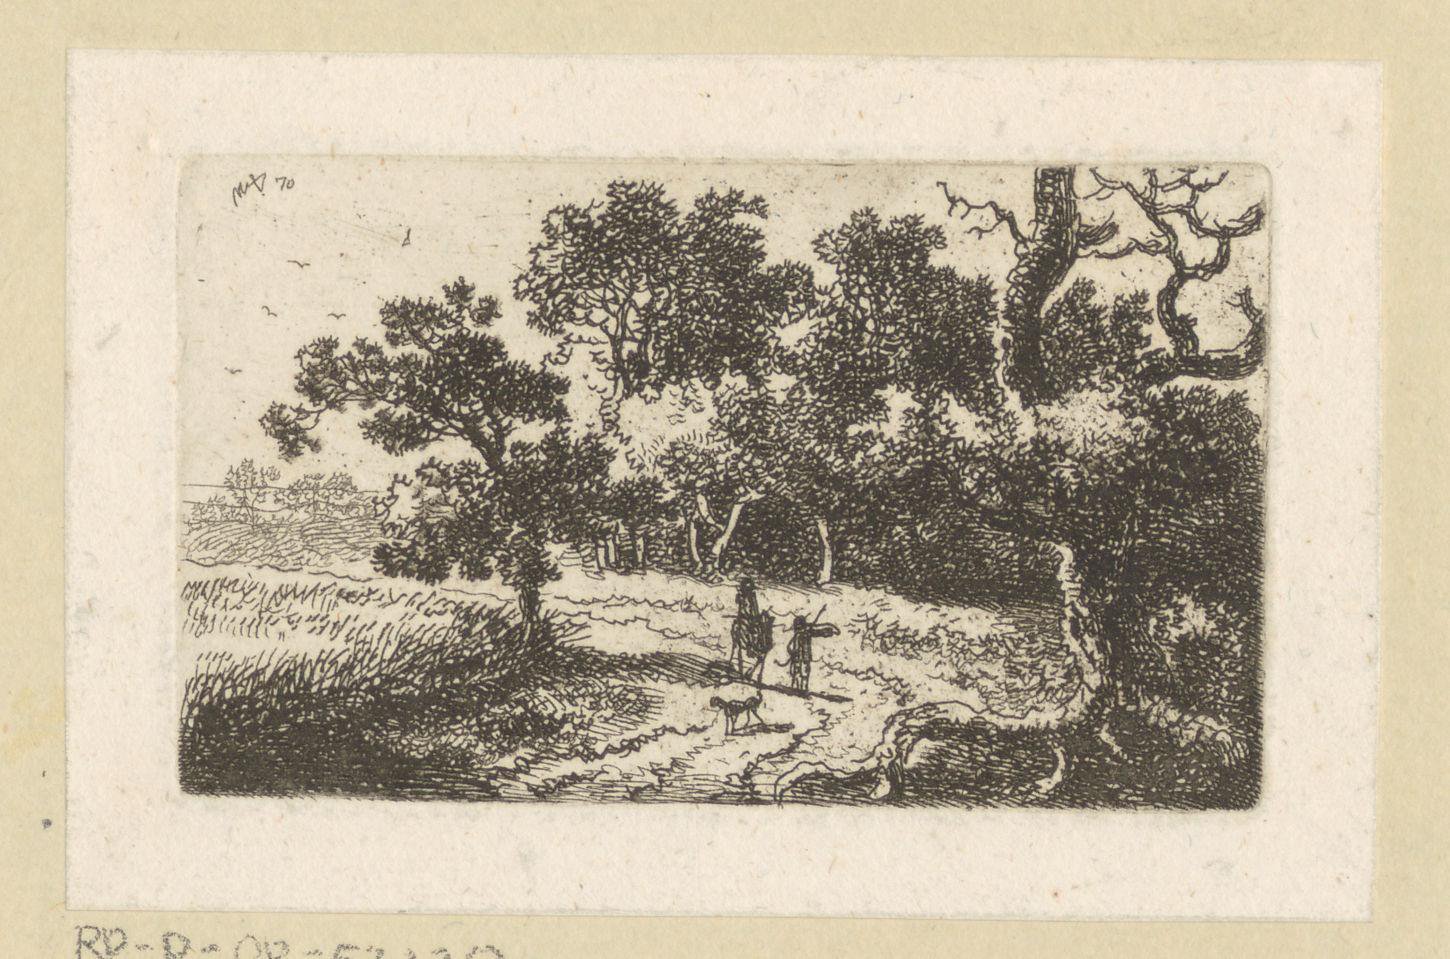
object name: print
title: Landschap met reizigers op een pad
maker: johann christian klengel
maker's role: print maker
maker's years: 1751-1824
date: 1770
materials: paper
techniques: etching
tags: forest path or lane, 'en route', traveller under way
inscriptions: collector's mark: Lugt 240